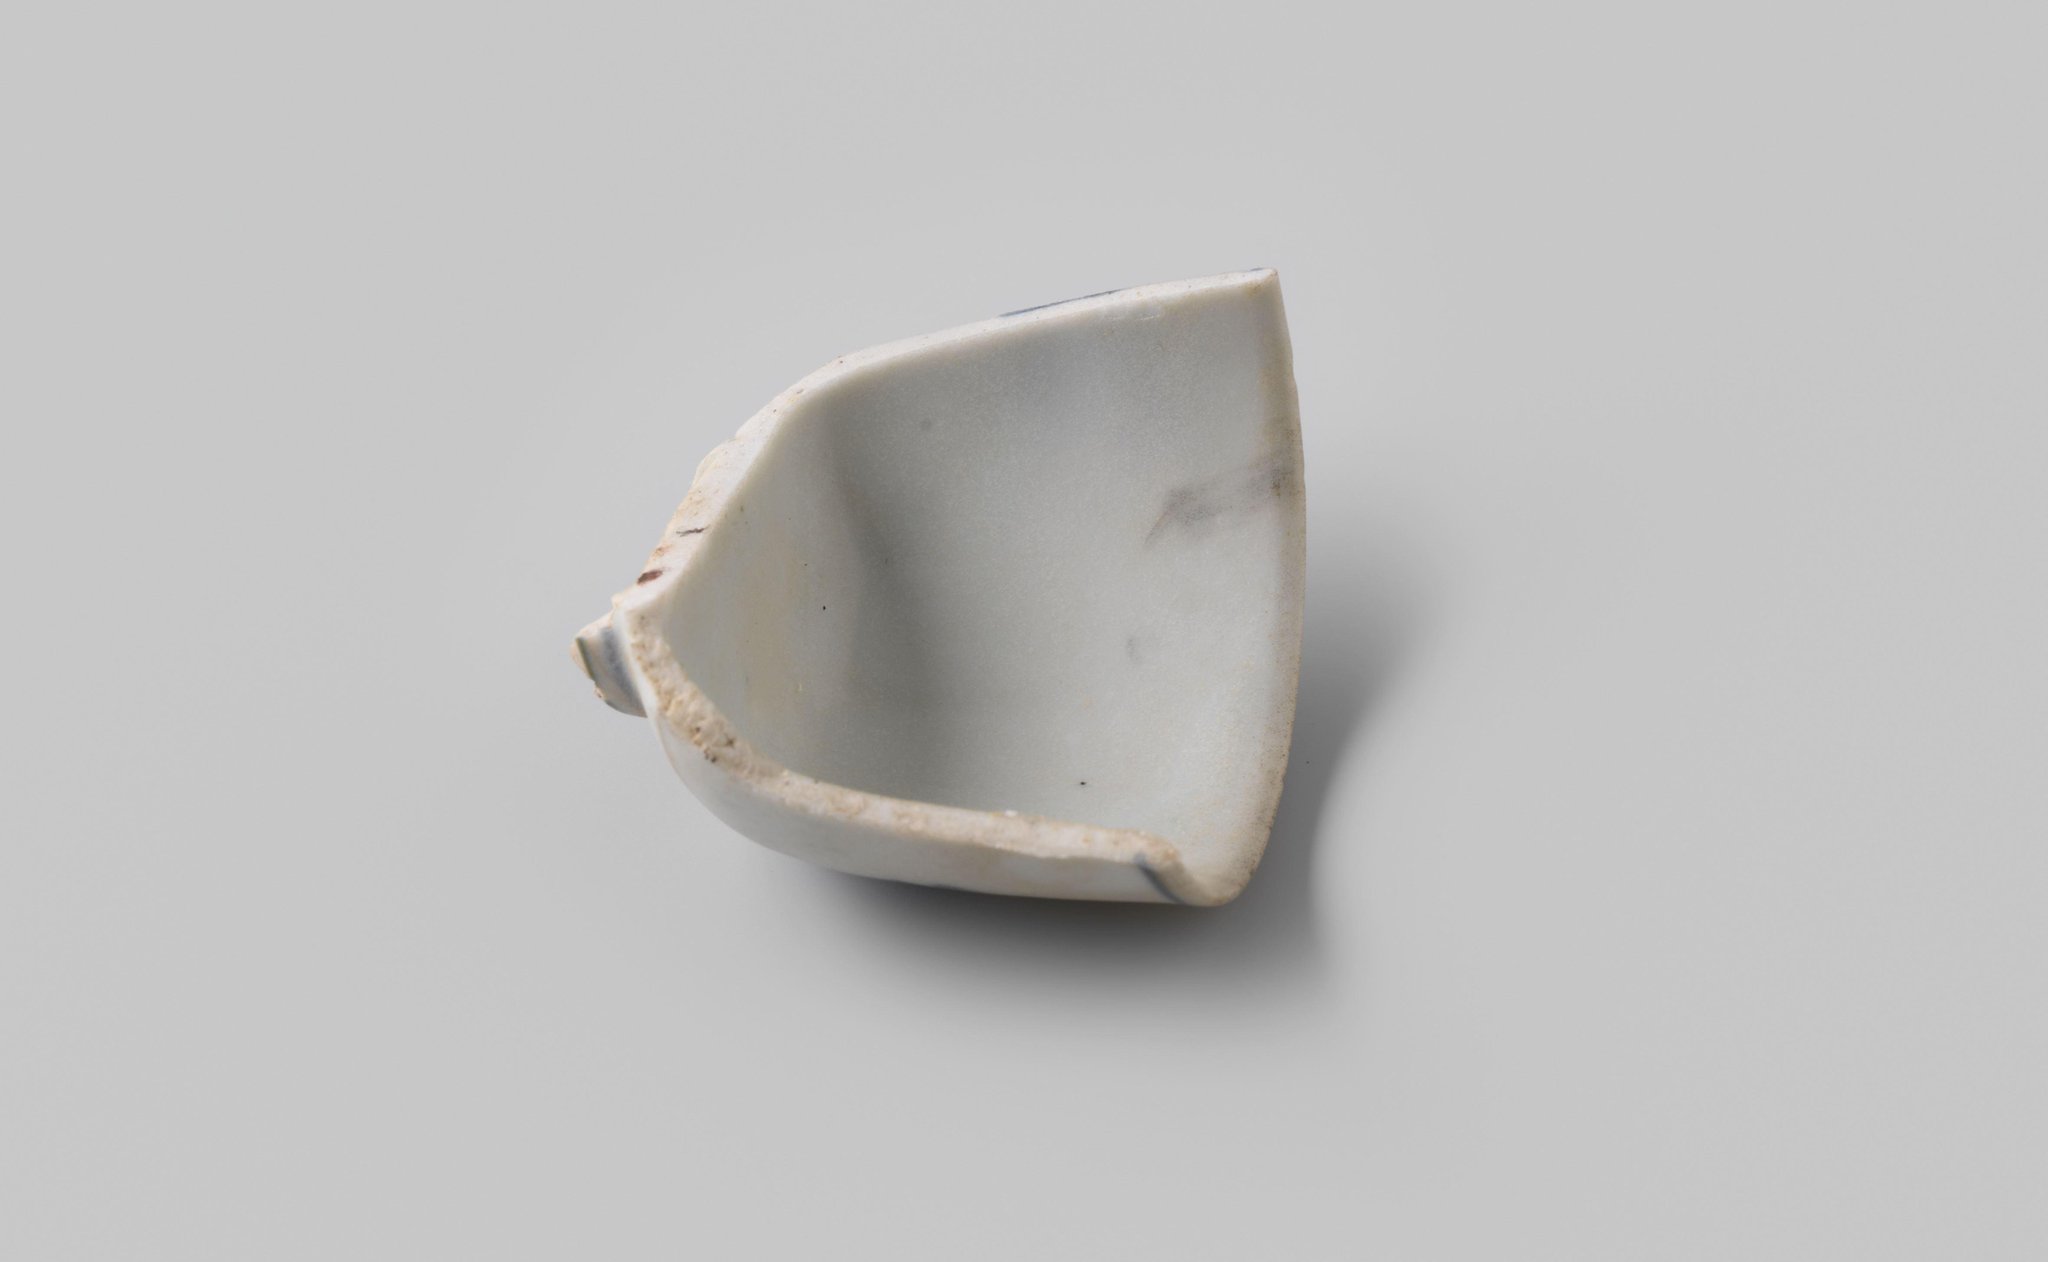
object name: sherd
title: Fragment wijnkom uit V.O.C.-schip de 'Witte Leeuw'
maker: Anonymous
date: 1613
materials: porcelain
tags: verenigde oostindische compagnie, sint-helena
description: The inside of the cup is undecorated. On the outside two sketchy flowers on elongated stems with an insect in between are drawn. There are about 20 such cups